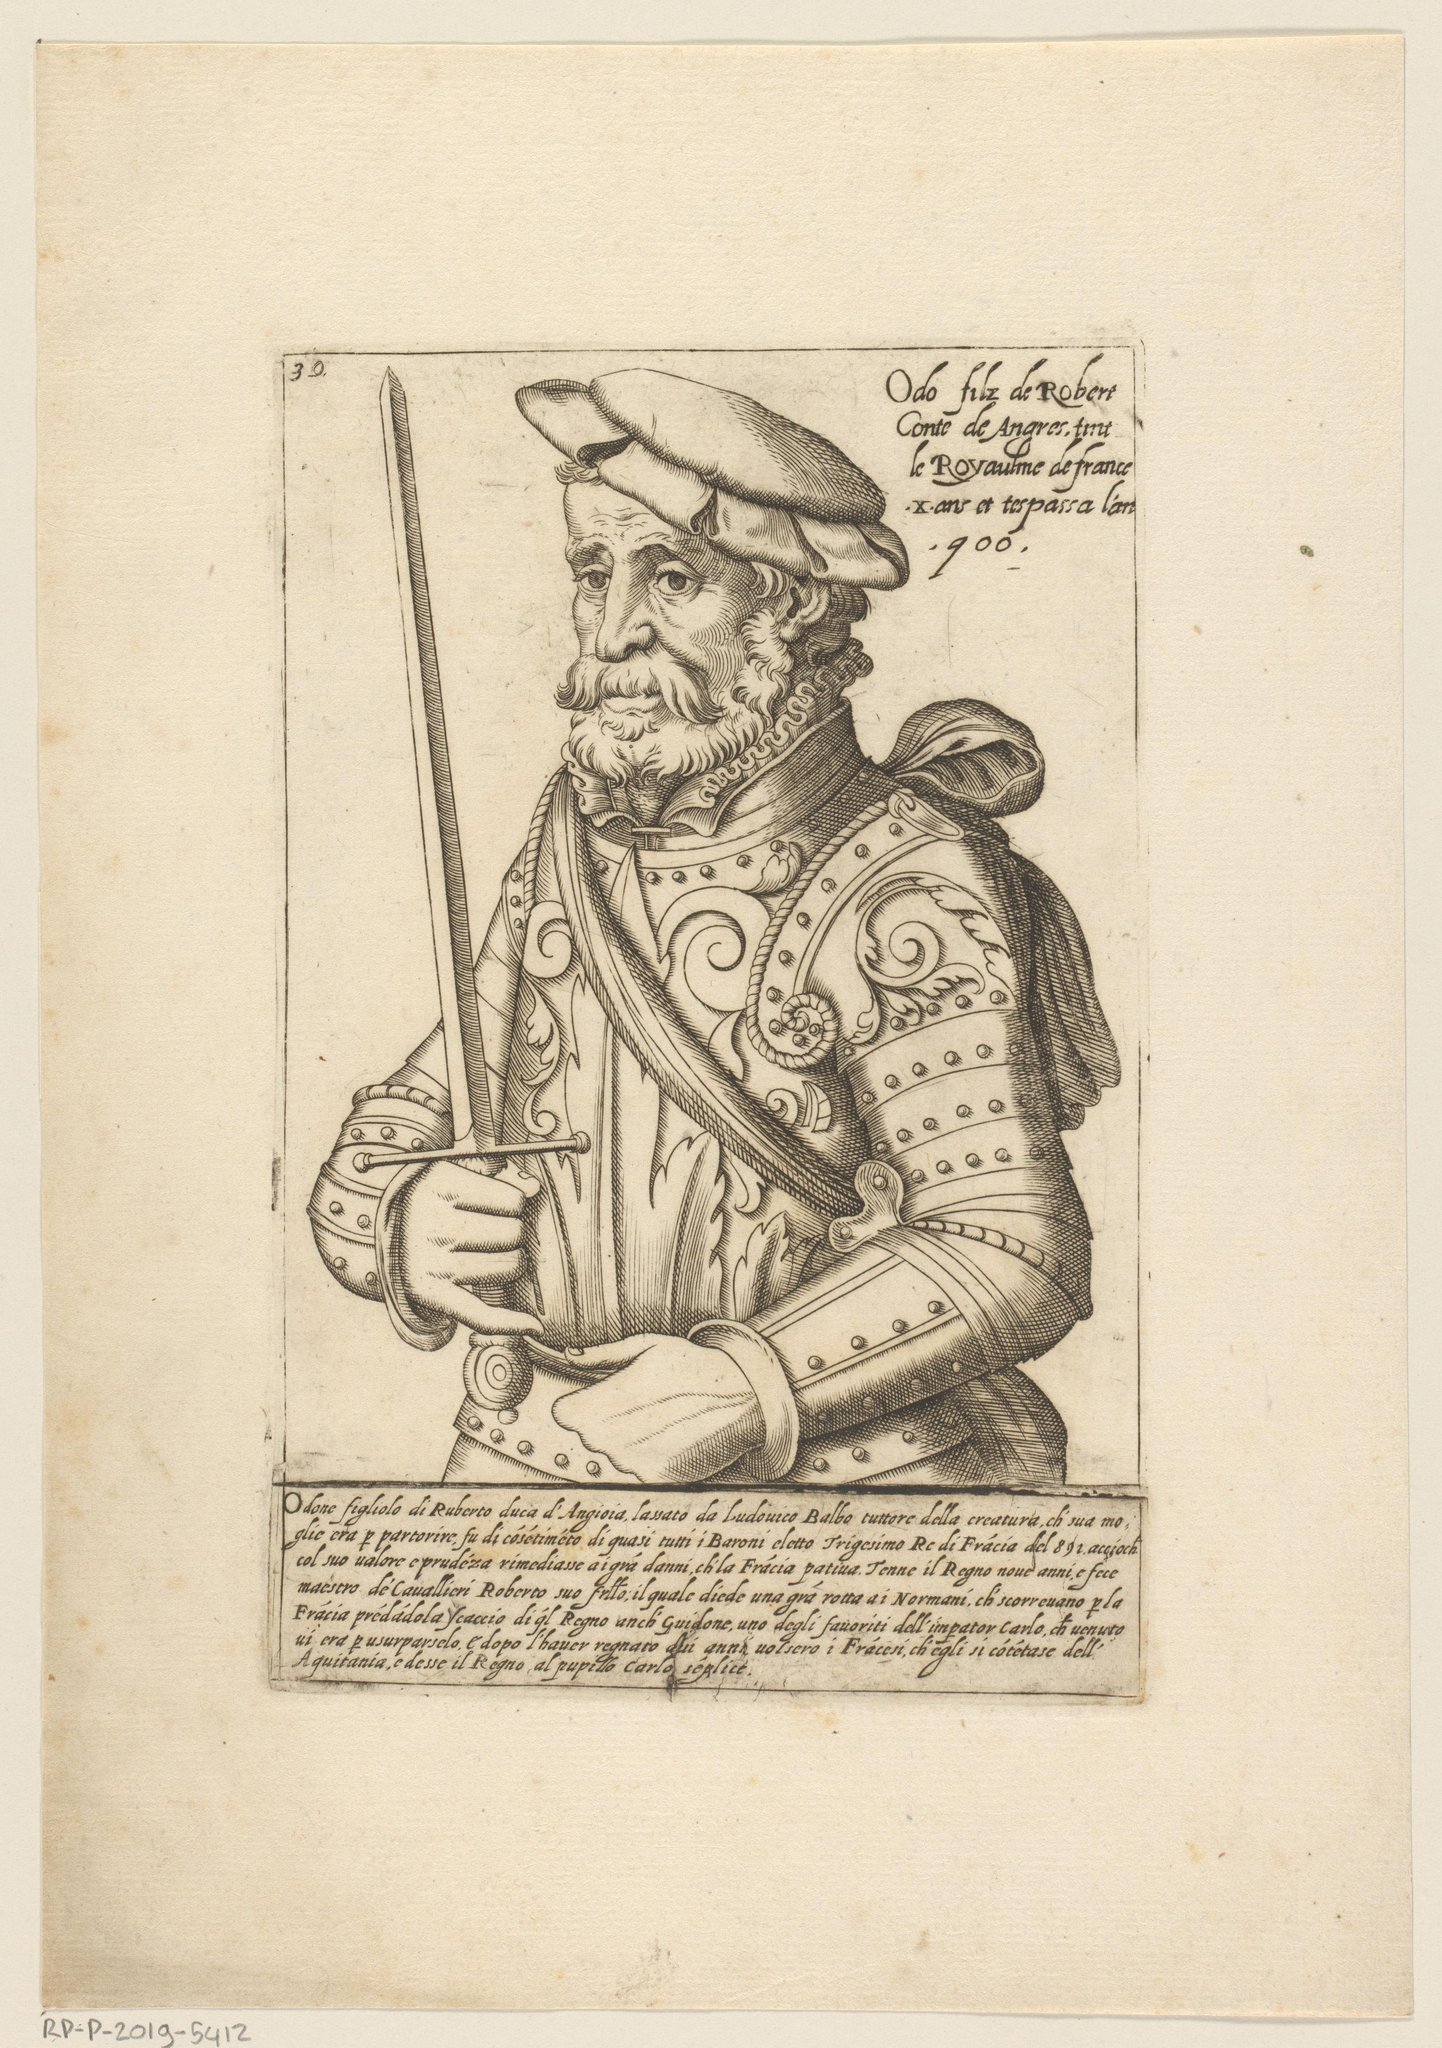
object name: book illustration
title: Portret van Odo I, koning van West-Francië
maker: Anonymous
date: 1588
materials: paper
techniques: engraving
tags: historical persons, hacking and thrusting weapons: sword, head-gear: beret, king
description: Prent voor het eerst gebruikt in: Cronica Breve de i fatti illustri de're di Francia, con le loro effigie dal naturale cominciando da Faramondo (...). Venetië: Bernardo Giunti, 1588. Prent in ieder geval ook gebruikt in de editie van 1590 en mogelijk ook in een Franse uitgave van 1597.